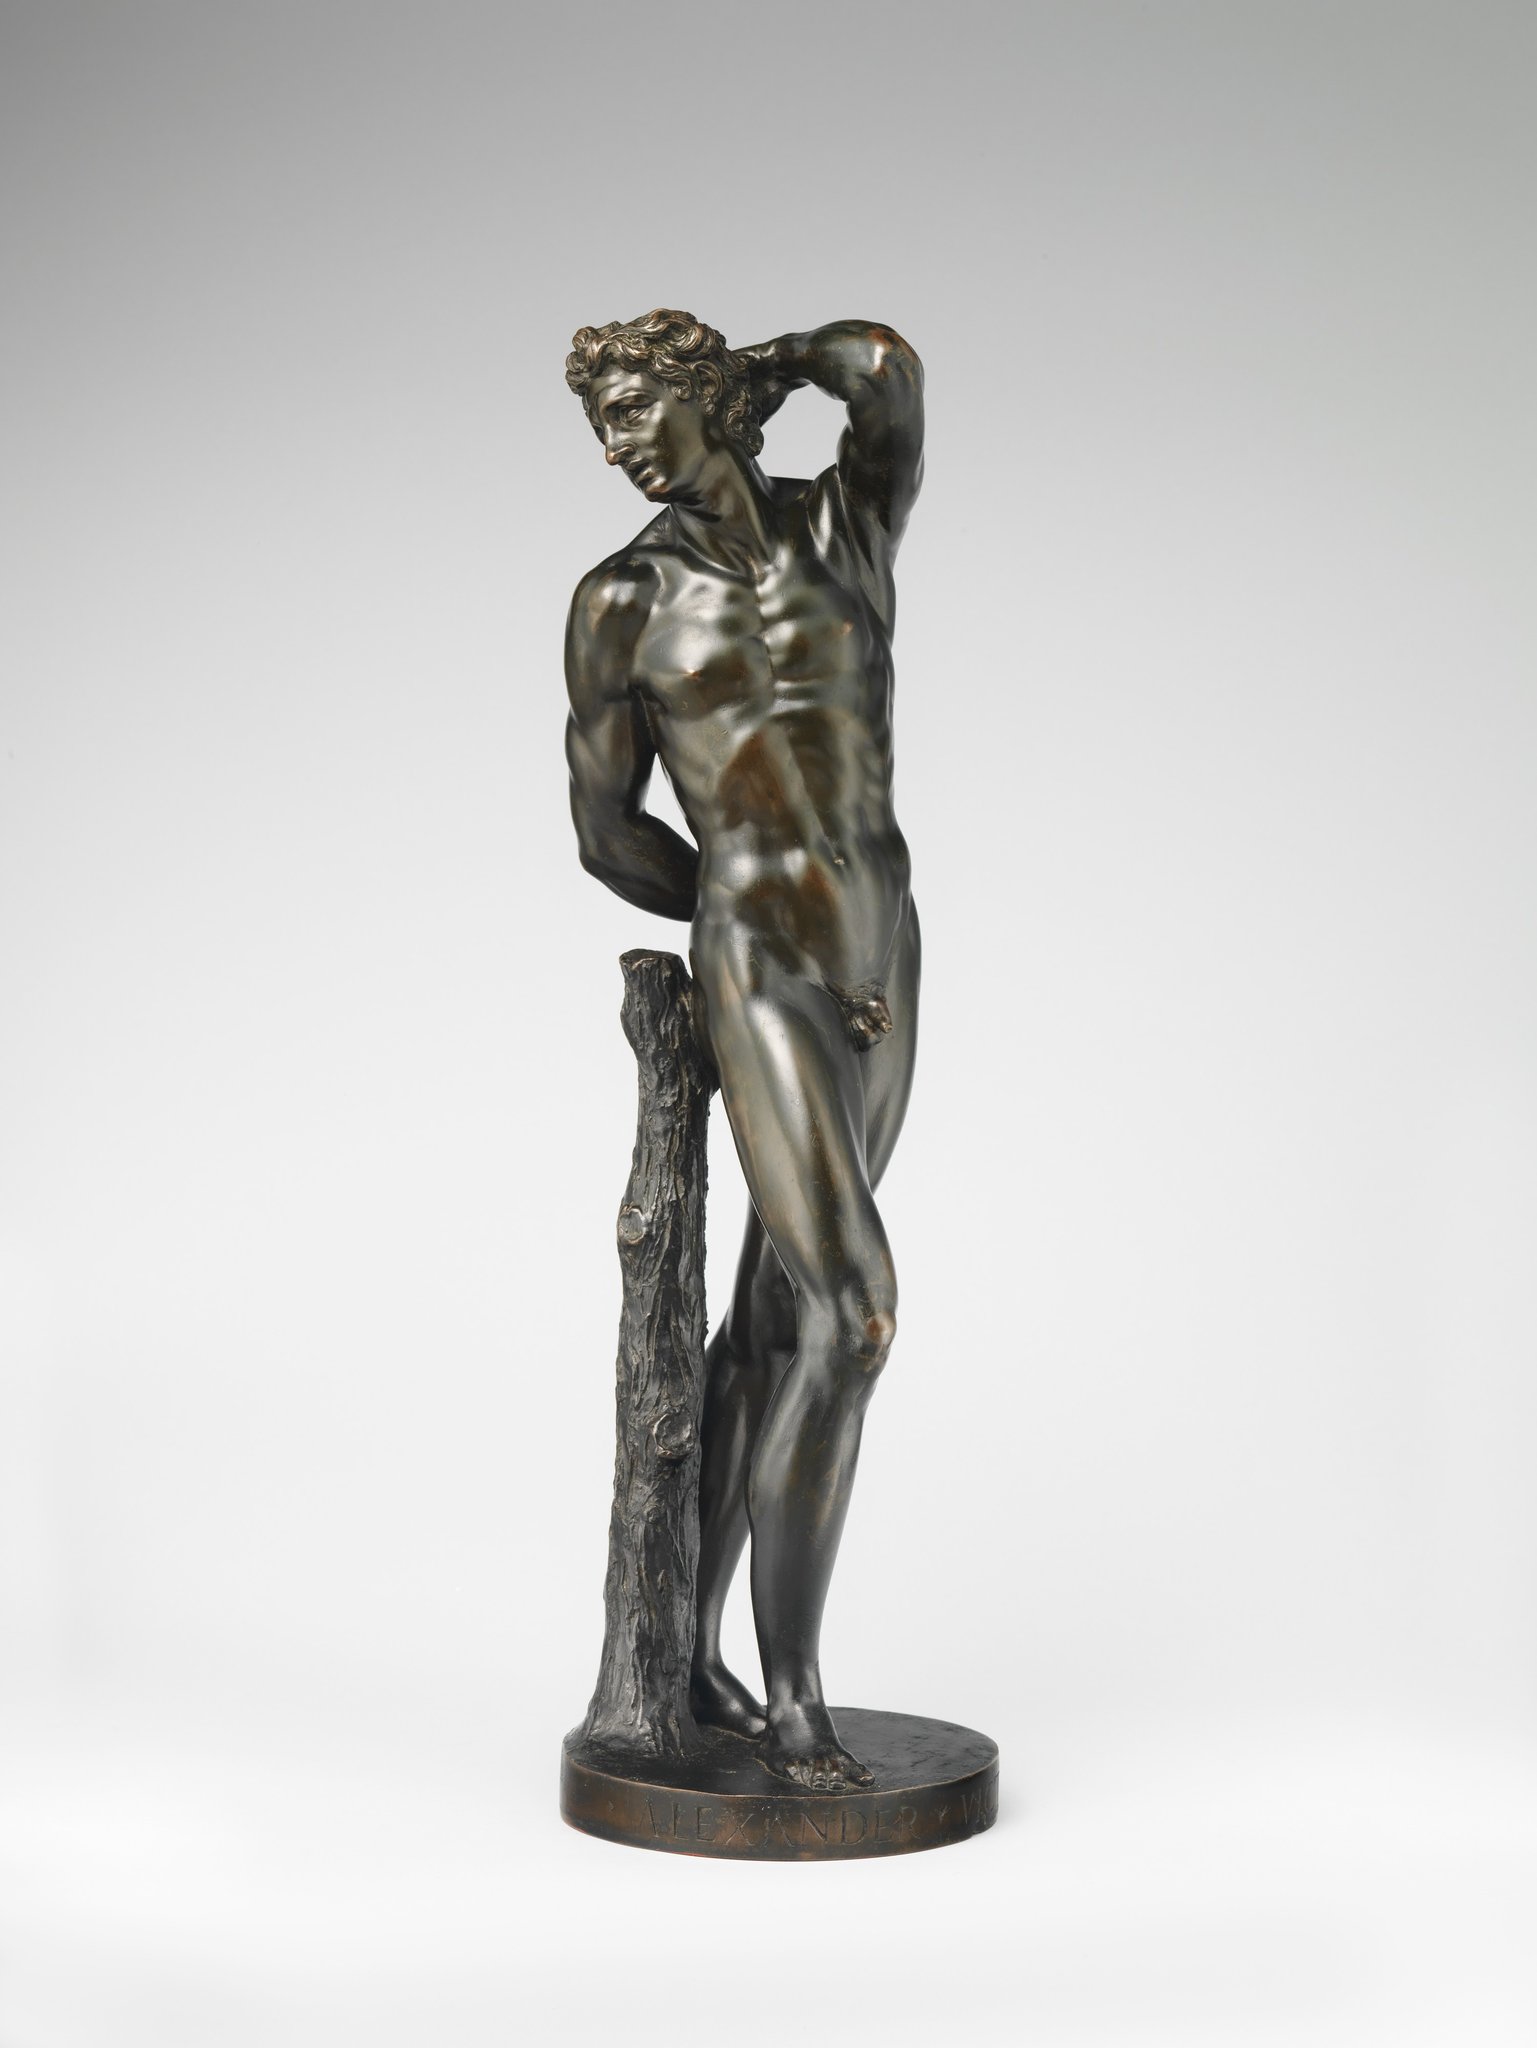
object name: statuette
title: Saint Sebastian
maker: alessandro vittoria (alessandro vittoria di vigilio della volpa)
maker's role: artist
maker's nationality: italian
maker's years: 1525-1608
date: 1566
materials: bronze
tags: male nudes,saints